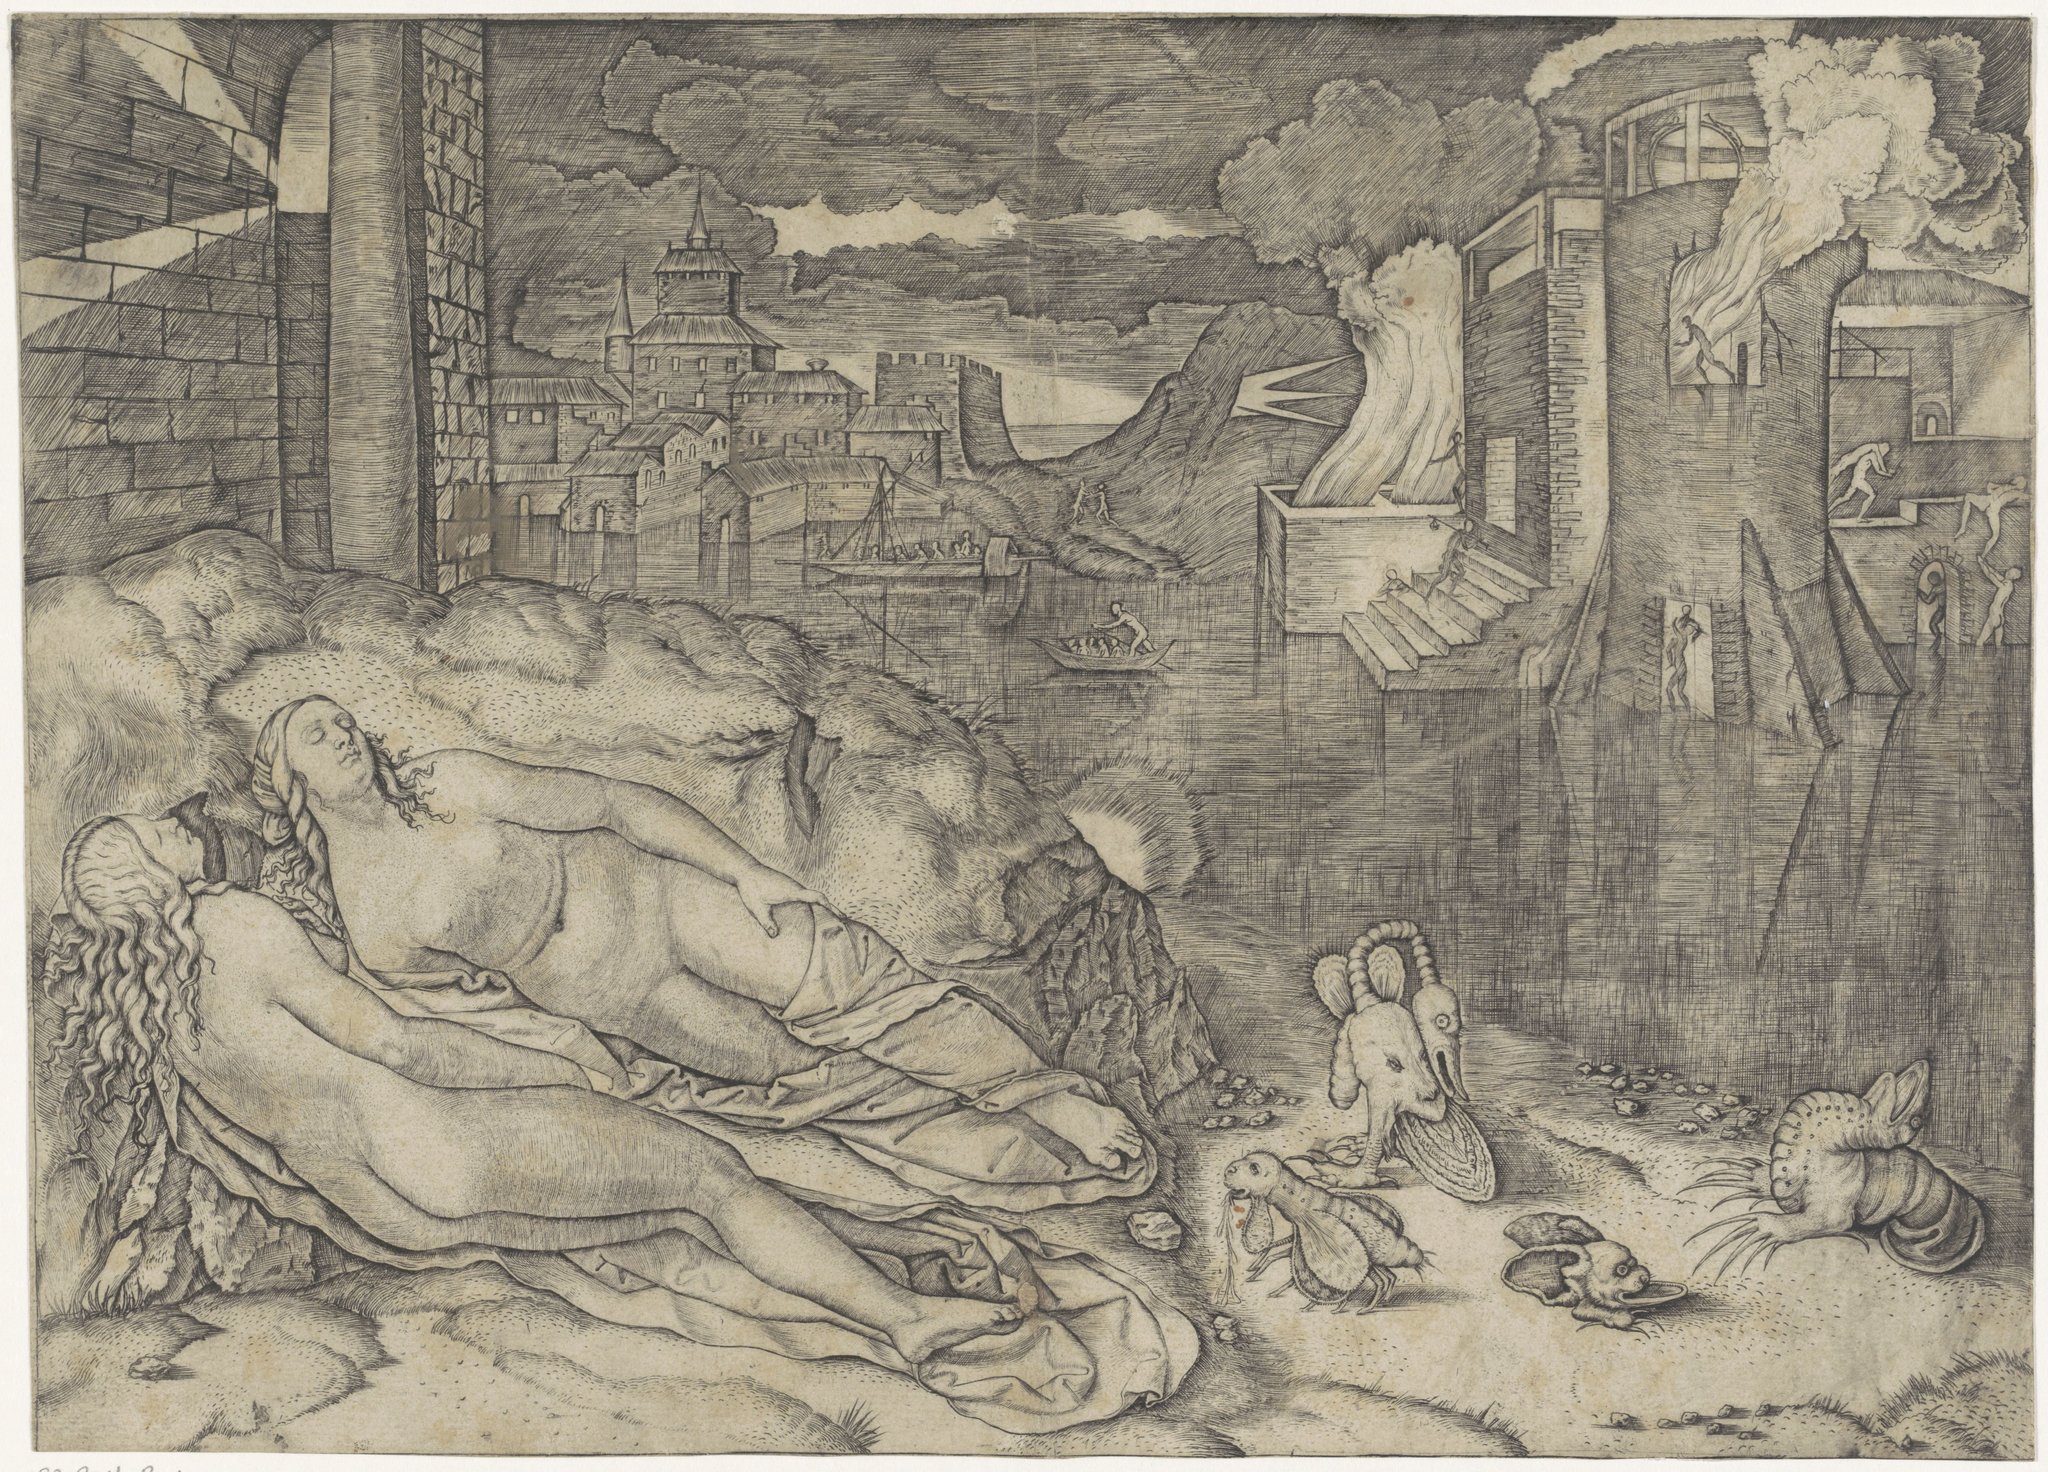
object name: print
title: Landschap met twee naakte slapende vrouwen en fantasiedieren op een oever bij water met brandend gebouw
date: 1505-1510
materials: paper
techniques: engraving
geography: italy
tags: fabulous animals (sometimes wrongly called 'grotesques'); 'mostri' (ripa), female sex; woman, ordeal by fire or heat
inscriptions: collector's mark: Lugt 10, collector's mark: Lugt 11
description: Volgens Delaborde is deze prent geïnspireerd door een reis naar Venetië die Raimondi maakte. In de liggende vrouwen ziet hij invloed van Venetiaanse meesters (zie documentatie).